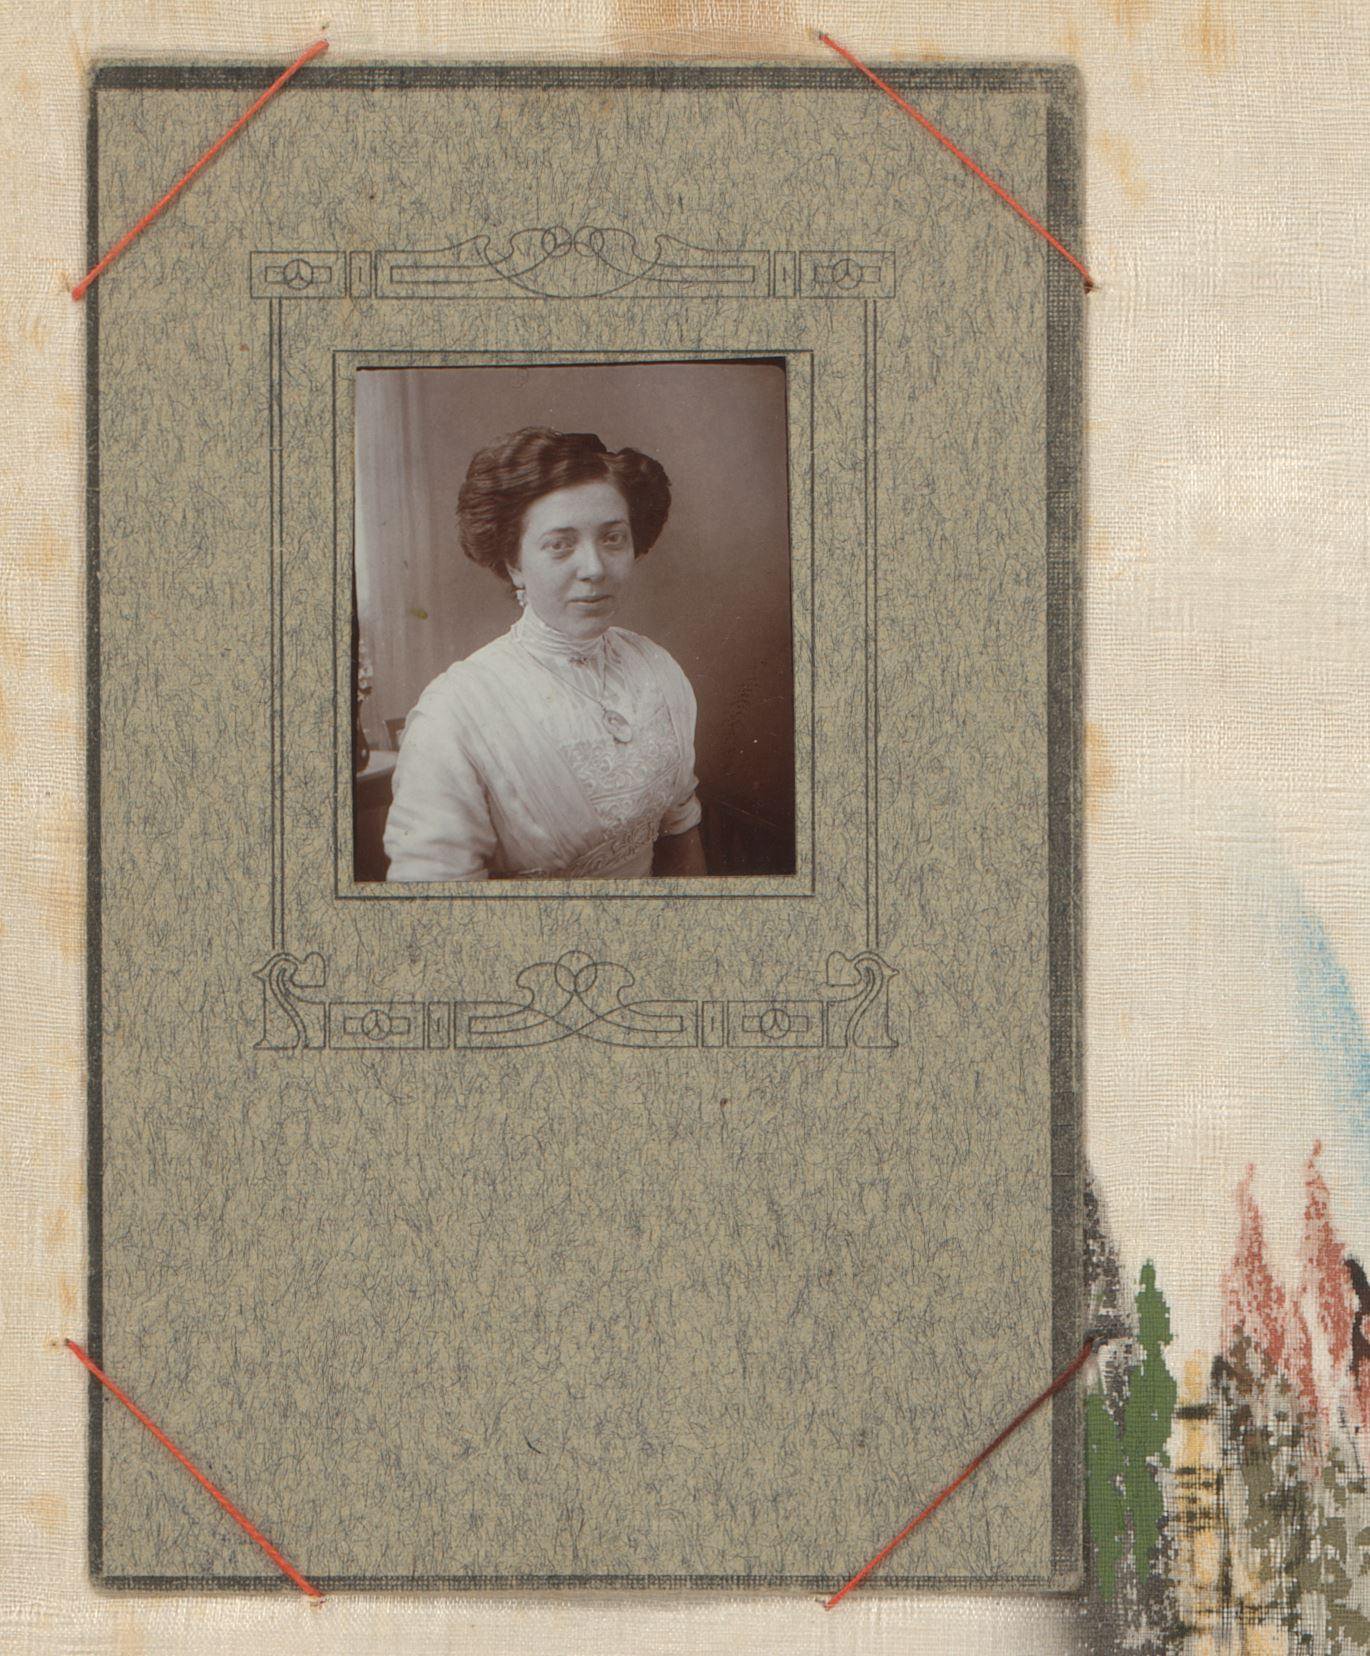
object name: photograph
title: Portret van een vrouw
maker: Anonymous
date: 1880-1910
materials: cardboard, paint, photographic support, silk, textile, watercolor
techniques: brush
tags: adult woman, historical persons